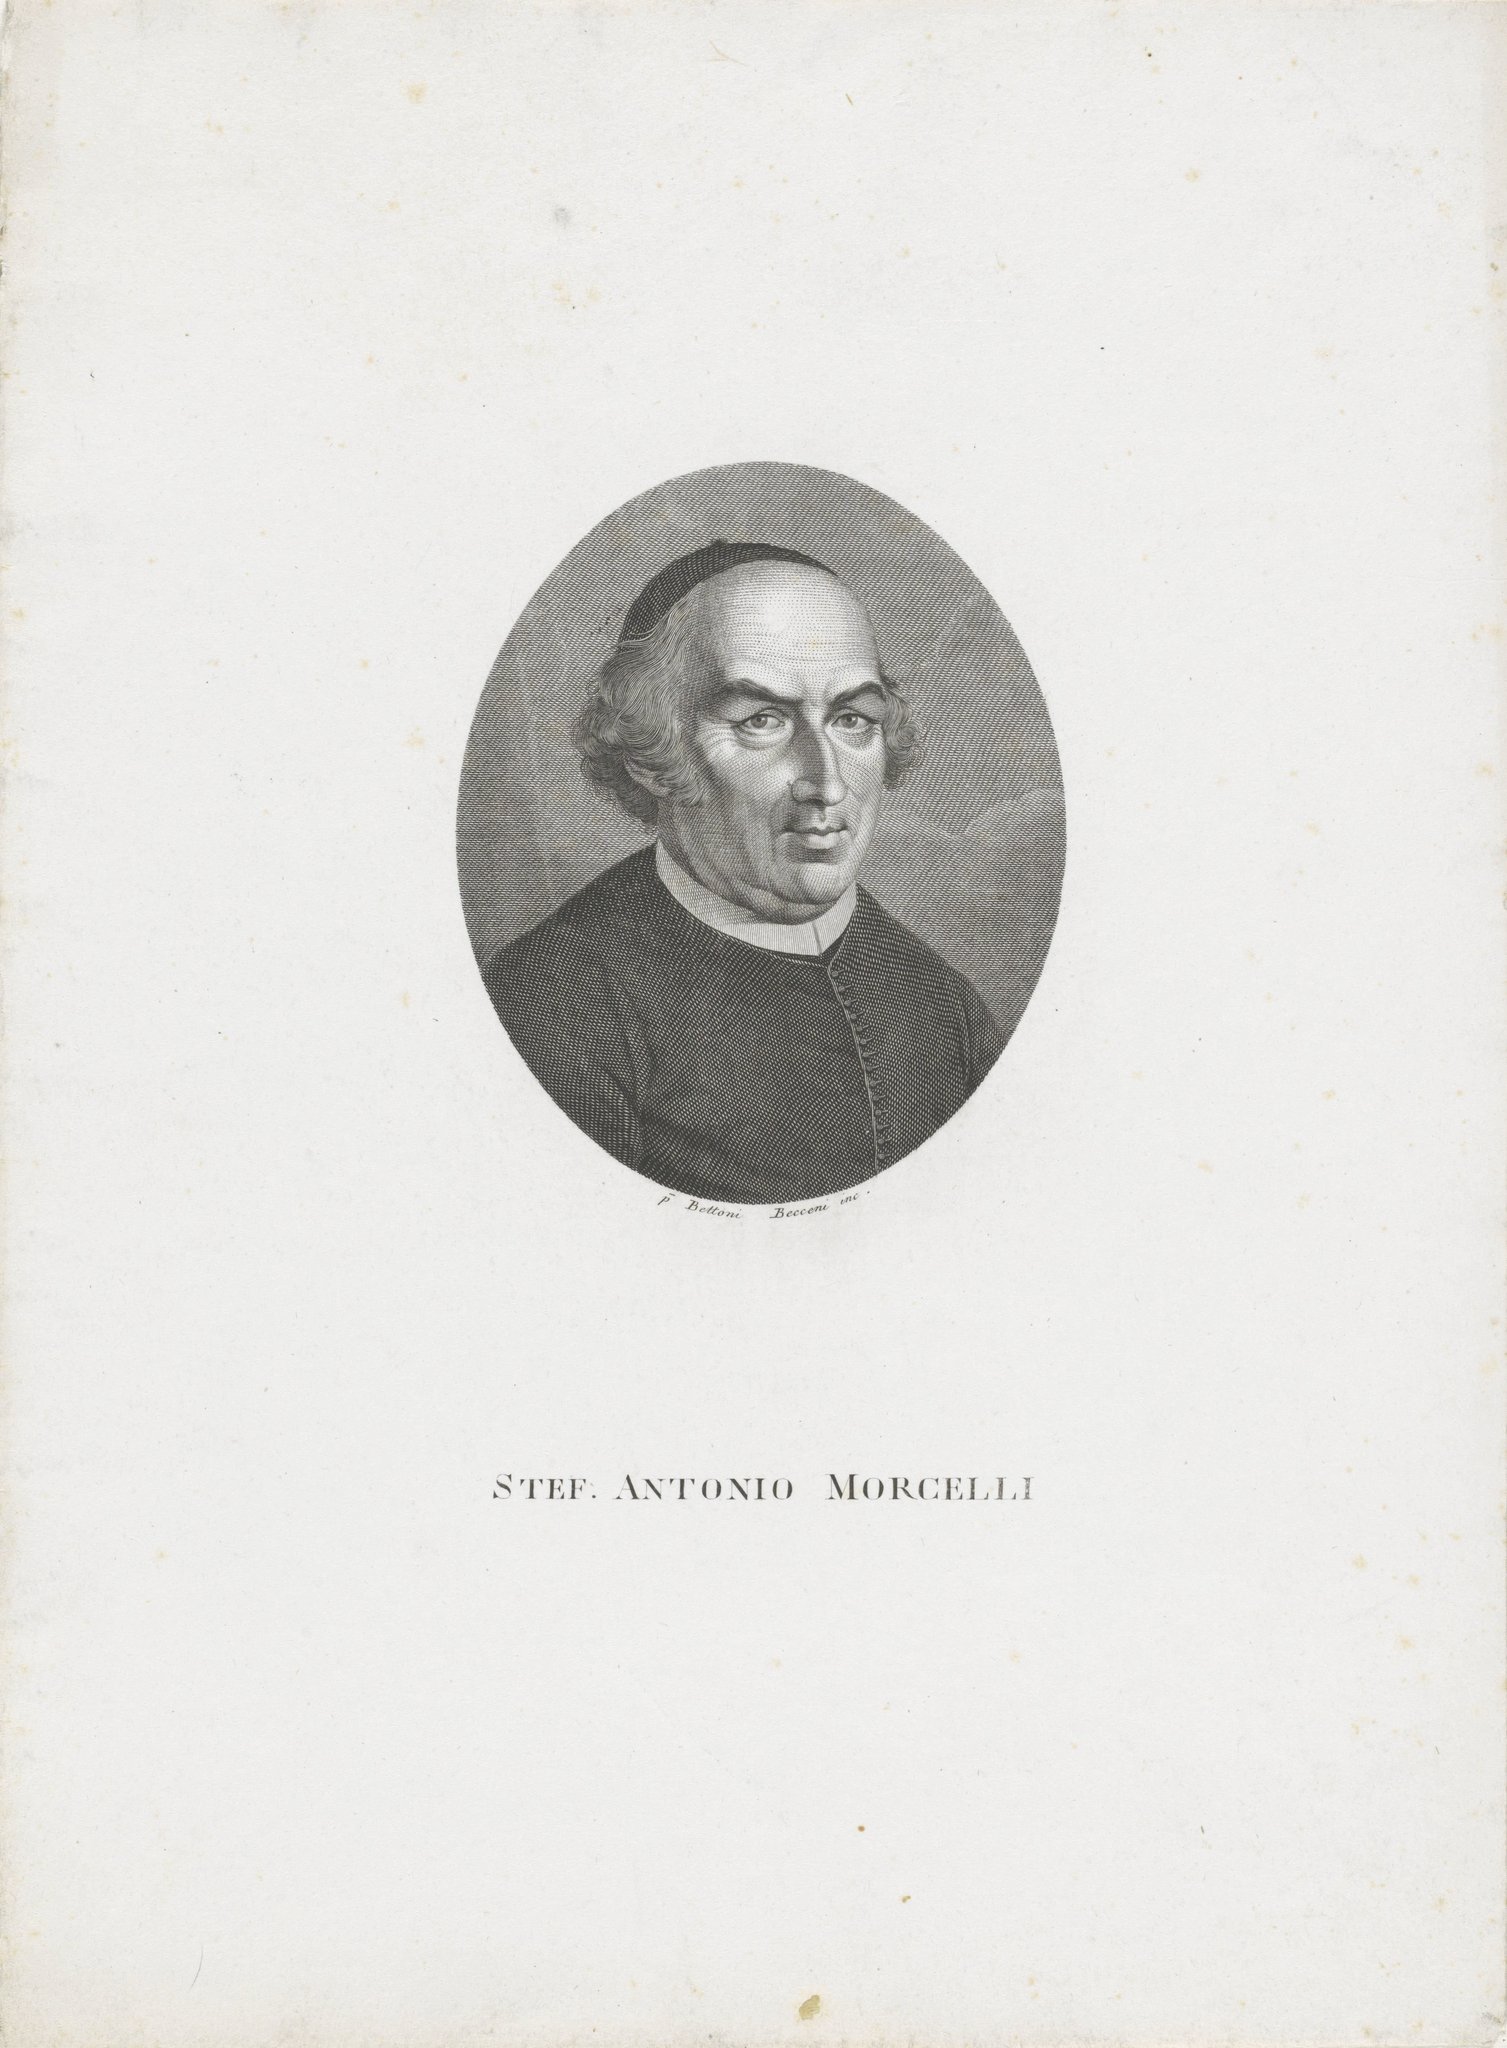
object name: print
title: Portret van Stefano Antonio Morcelli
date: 1765-1829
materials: paper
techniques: engraving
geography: italy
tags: historical persons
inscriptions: collector's mark: Lugt 2228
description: Deze prent maakt deel uit van een reeks portretprenten van onbekende omvang. De reeks is in meerdere staten uitgegeven. De eerste staat met enkel het portret in ovaal. Een tweede staat met naam van de geportretteerde in holle letters onder de voorstelling. Een derde staat met de naam van de geportretteerde in gevulde letters onder de voorstelling. En een vierde staat met een rechthoekig kader rondom het ovale portret.